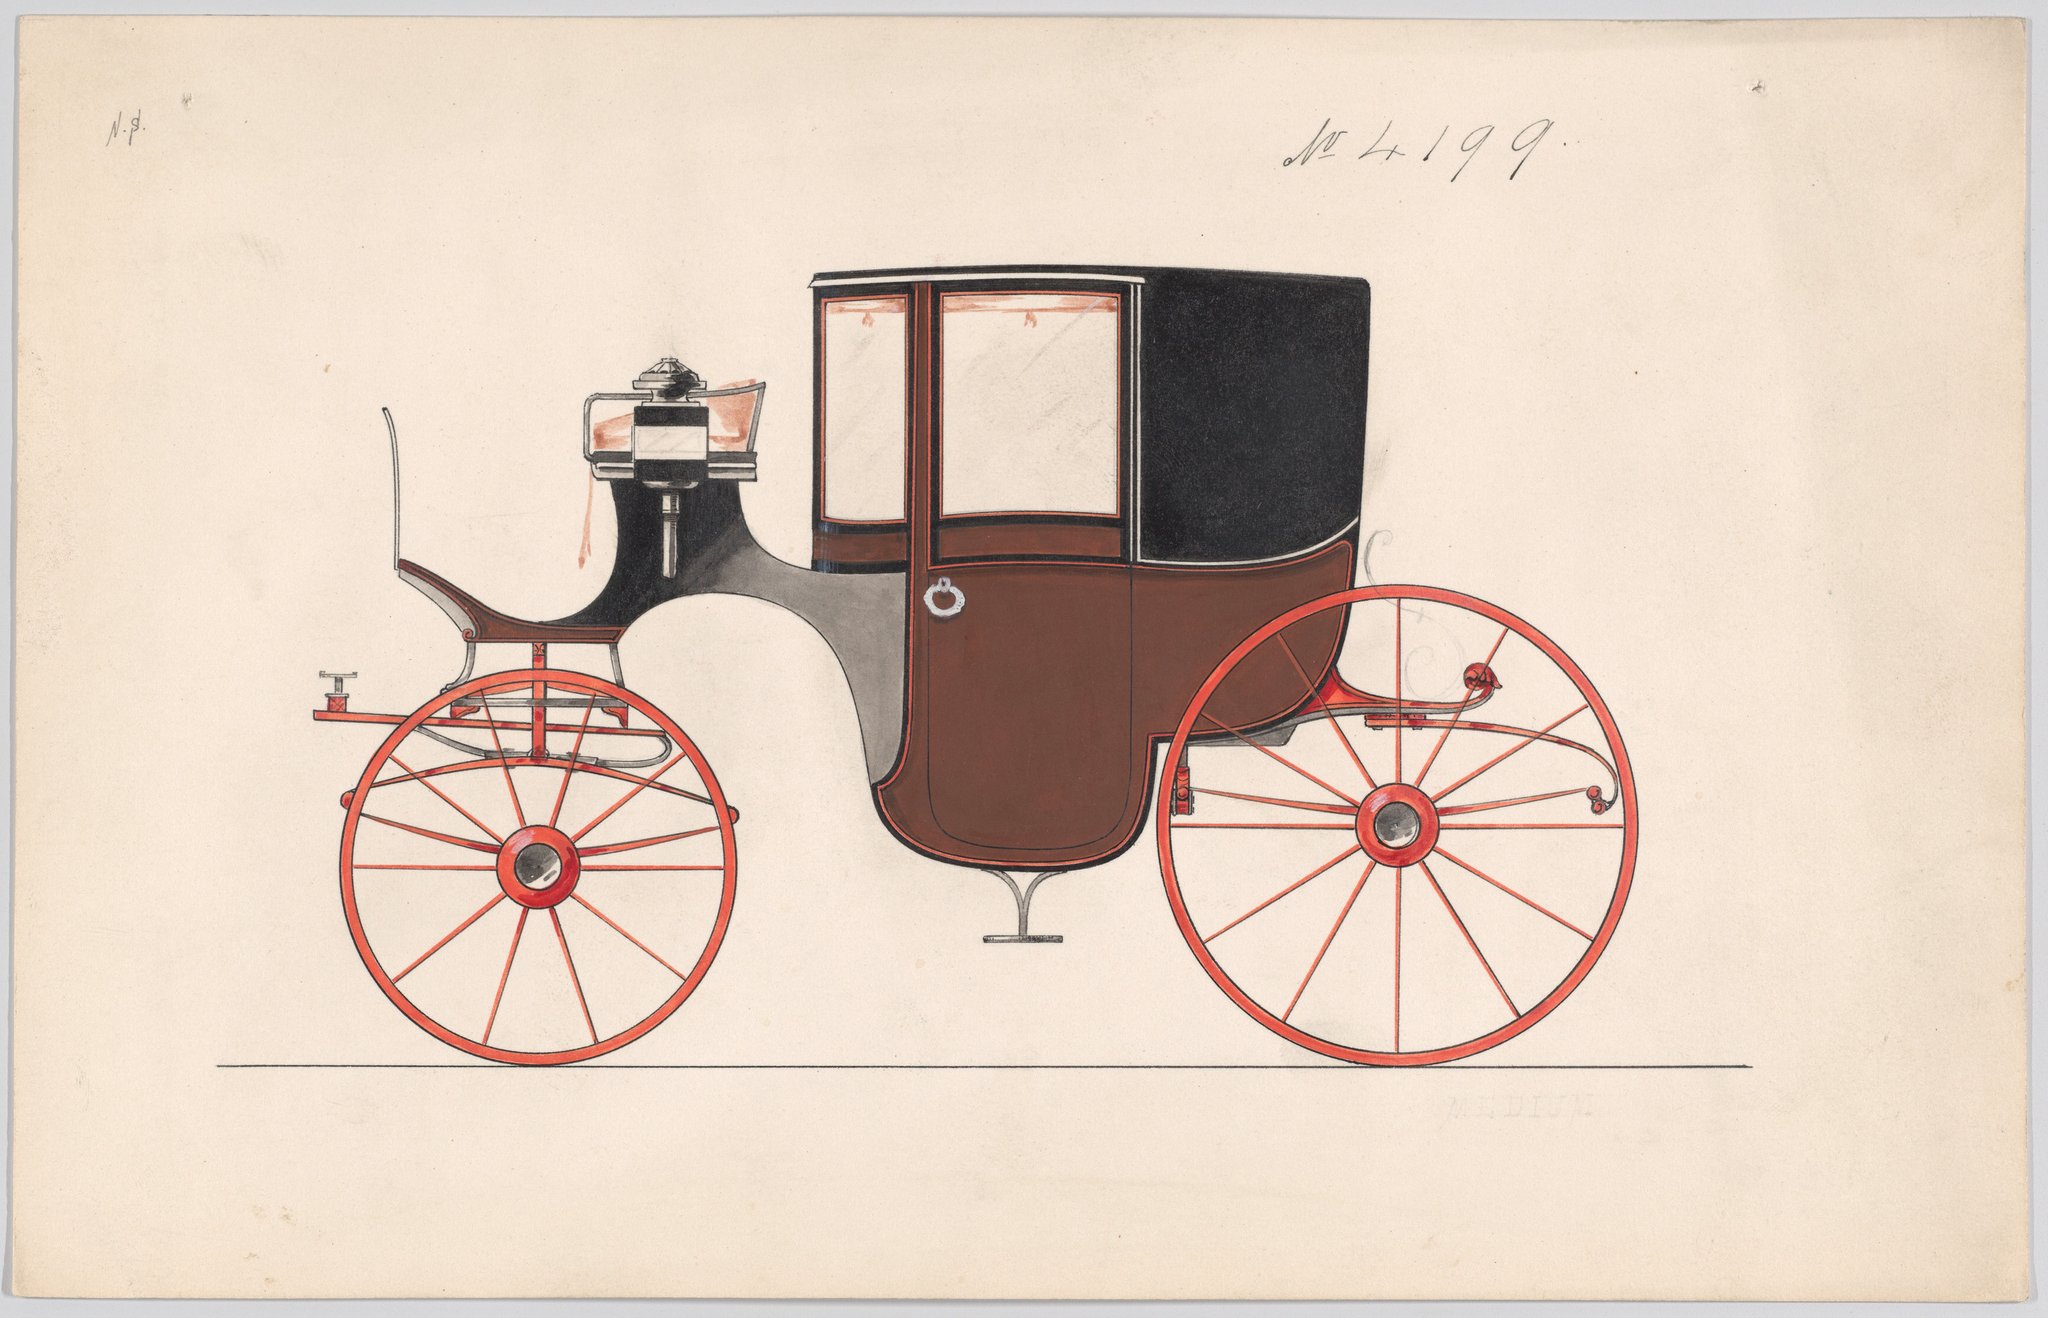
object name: drawing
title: Design for Coupé, no. 4199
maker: brewster & co.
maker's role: manufacturer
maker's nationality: american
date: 1892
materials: gouache, ink, watercolor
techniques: pen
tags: carriages